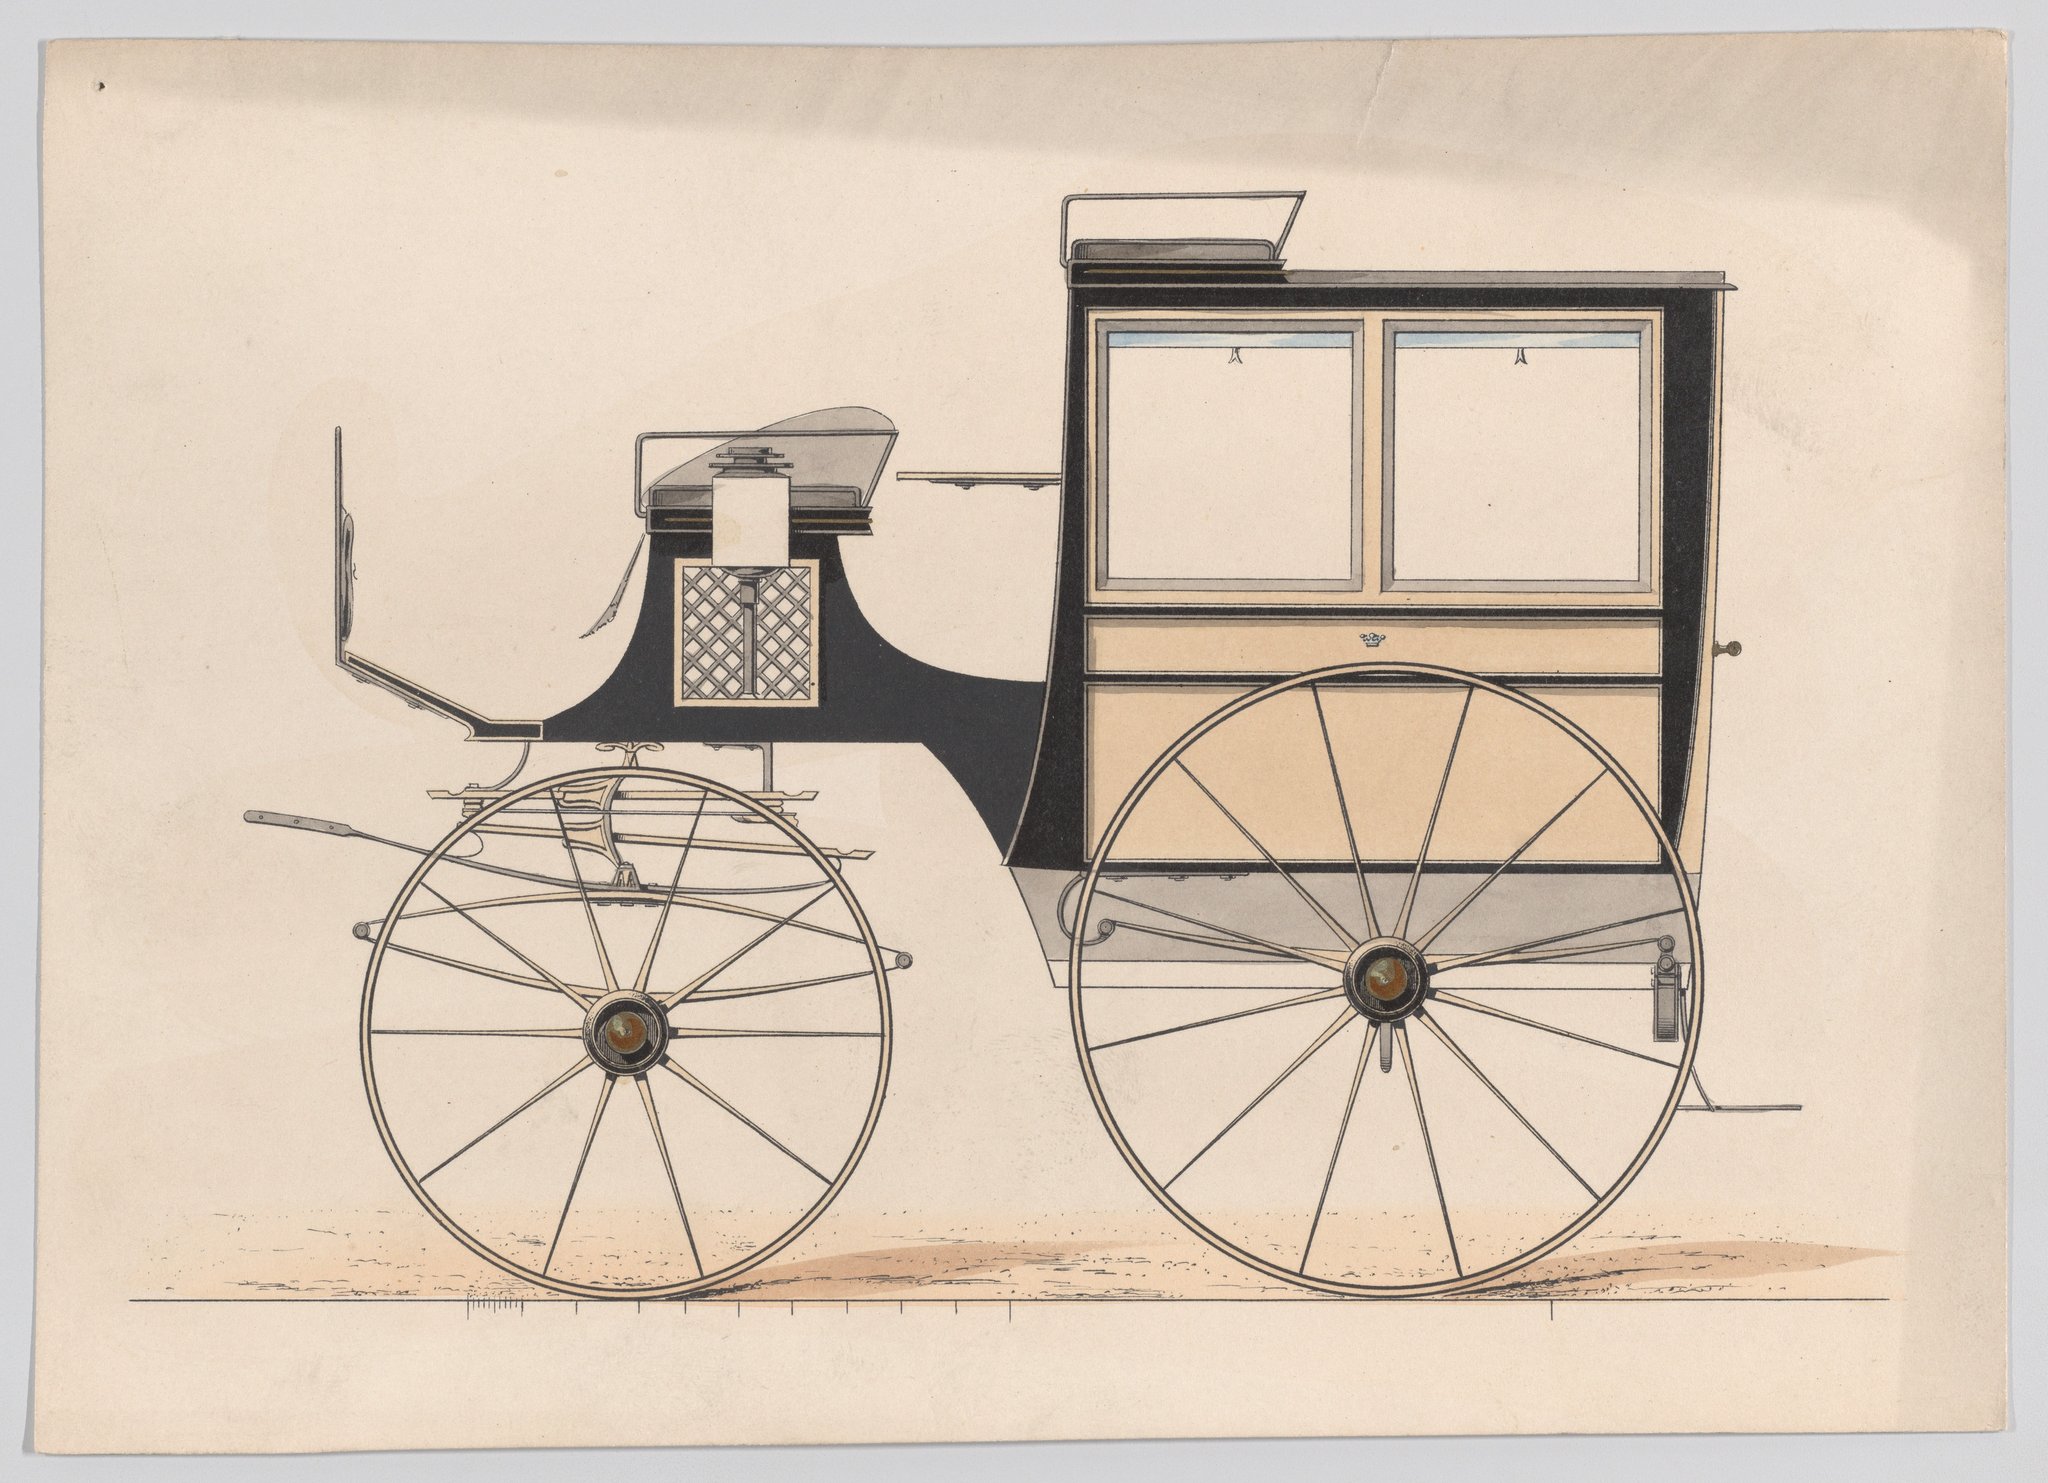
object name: print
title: Design for Open Bus or Private Omnibus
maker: anonymous, french, 19th century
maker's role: artist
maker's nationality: french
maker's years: 1800-1900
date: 1880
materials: gum arabic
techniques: hand coloring, lithograph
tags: carriages